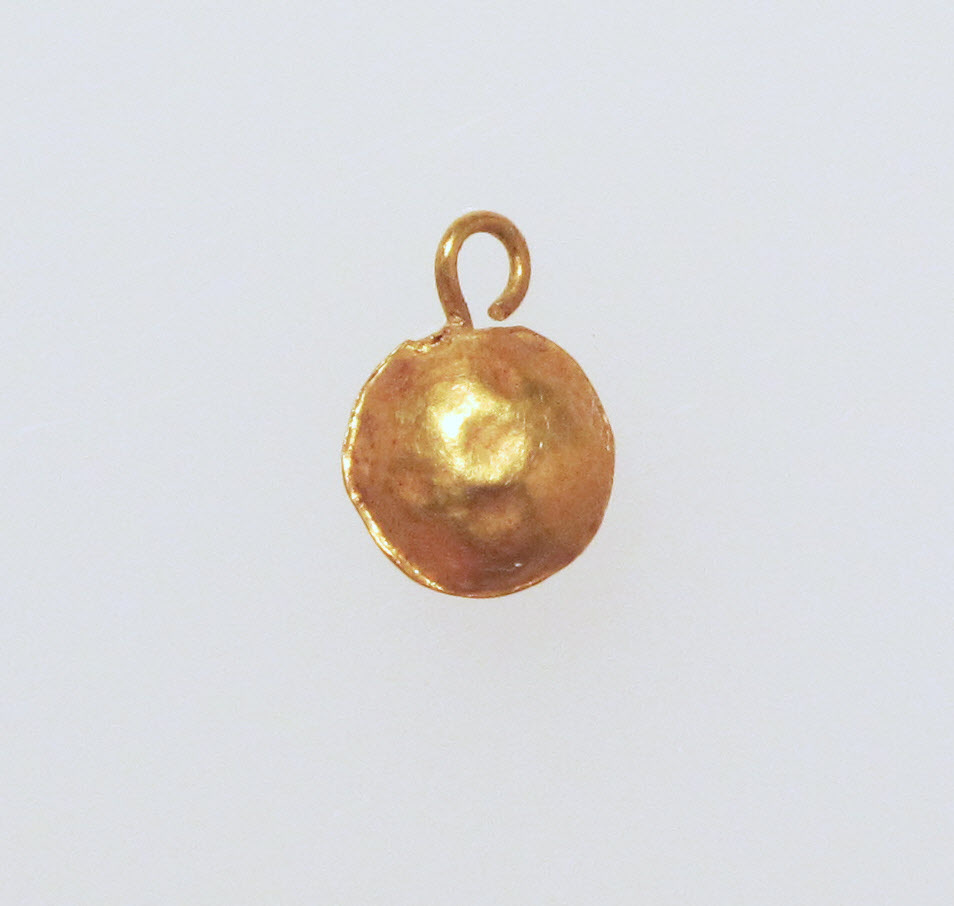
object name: pendant, lentoid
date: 7000 BCE-330 CE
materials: gold